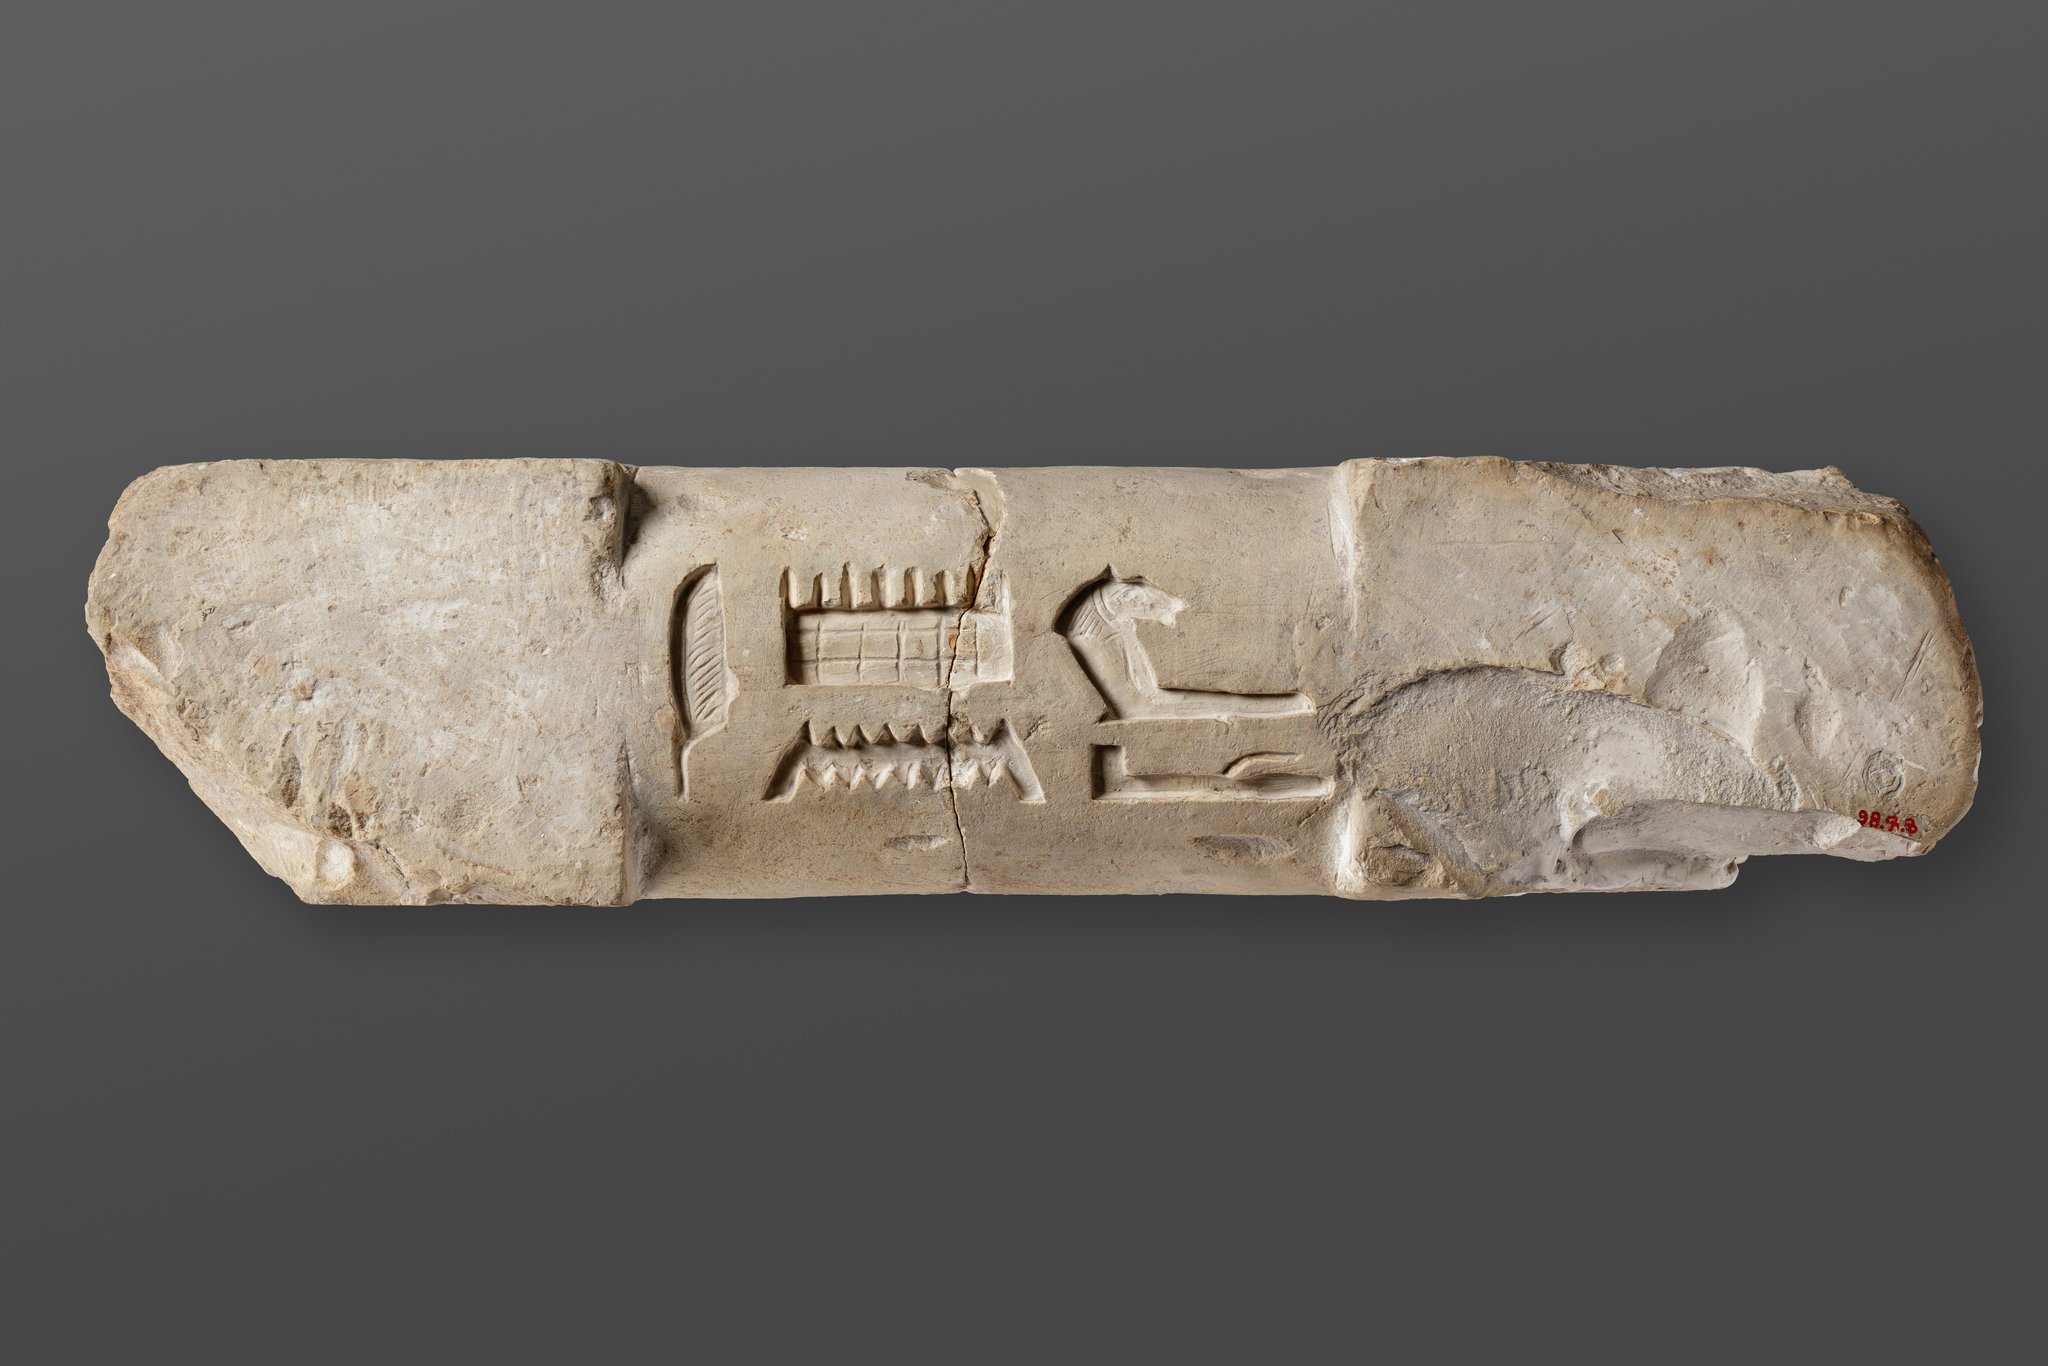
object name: door drum fragment, tomb of meni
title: Fragment of a Door Drum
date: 2323-2150 BCE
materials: limestone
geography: egypt